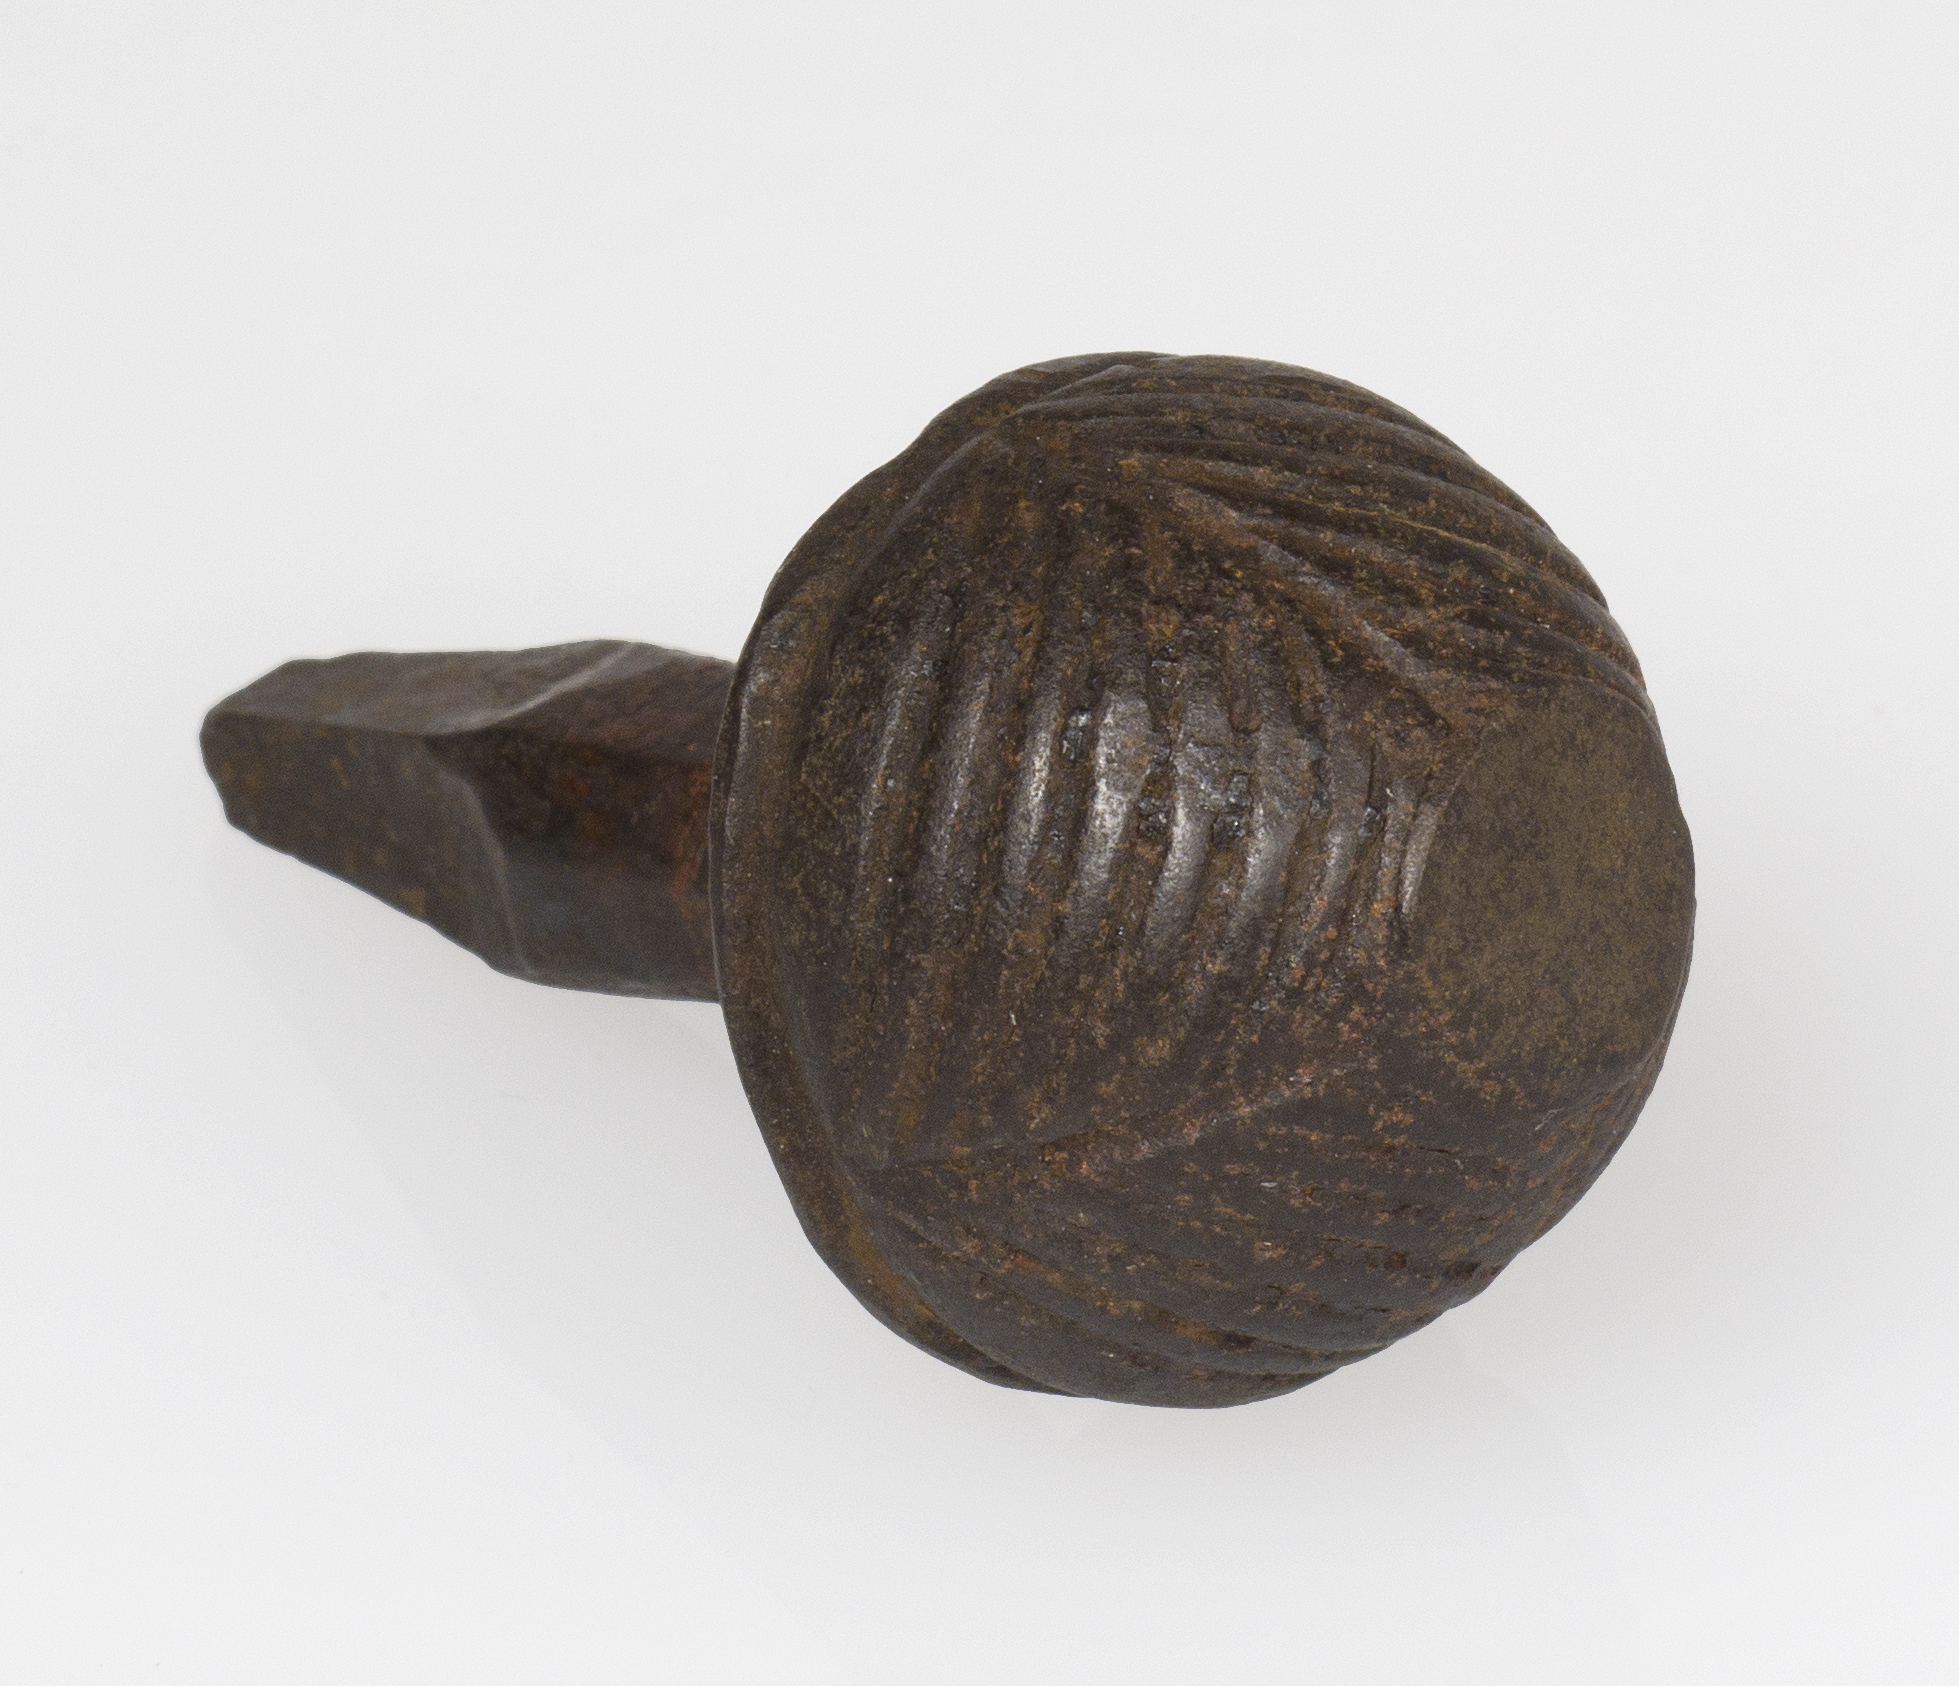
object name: nail head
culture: european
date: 1401-1600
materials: iron